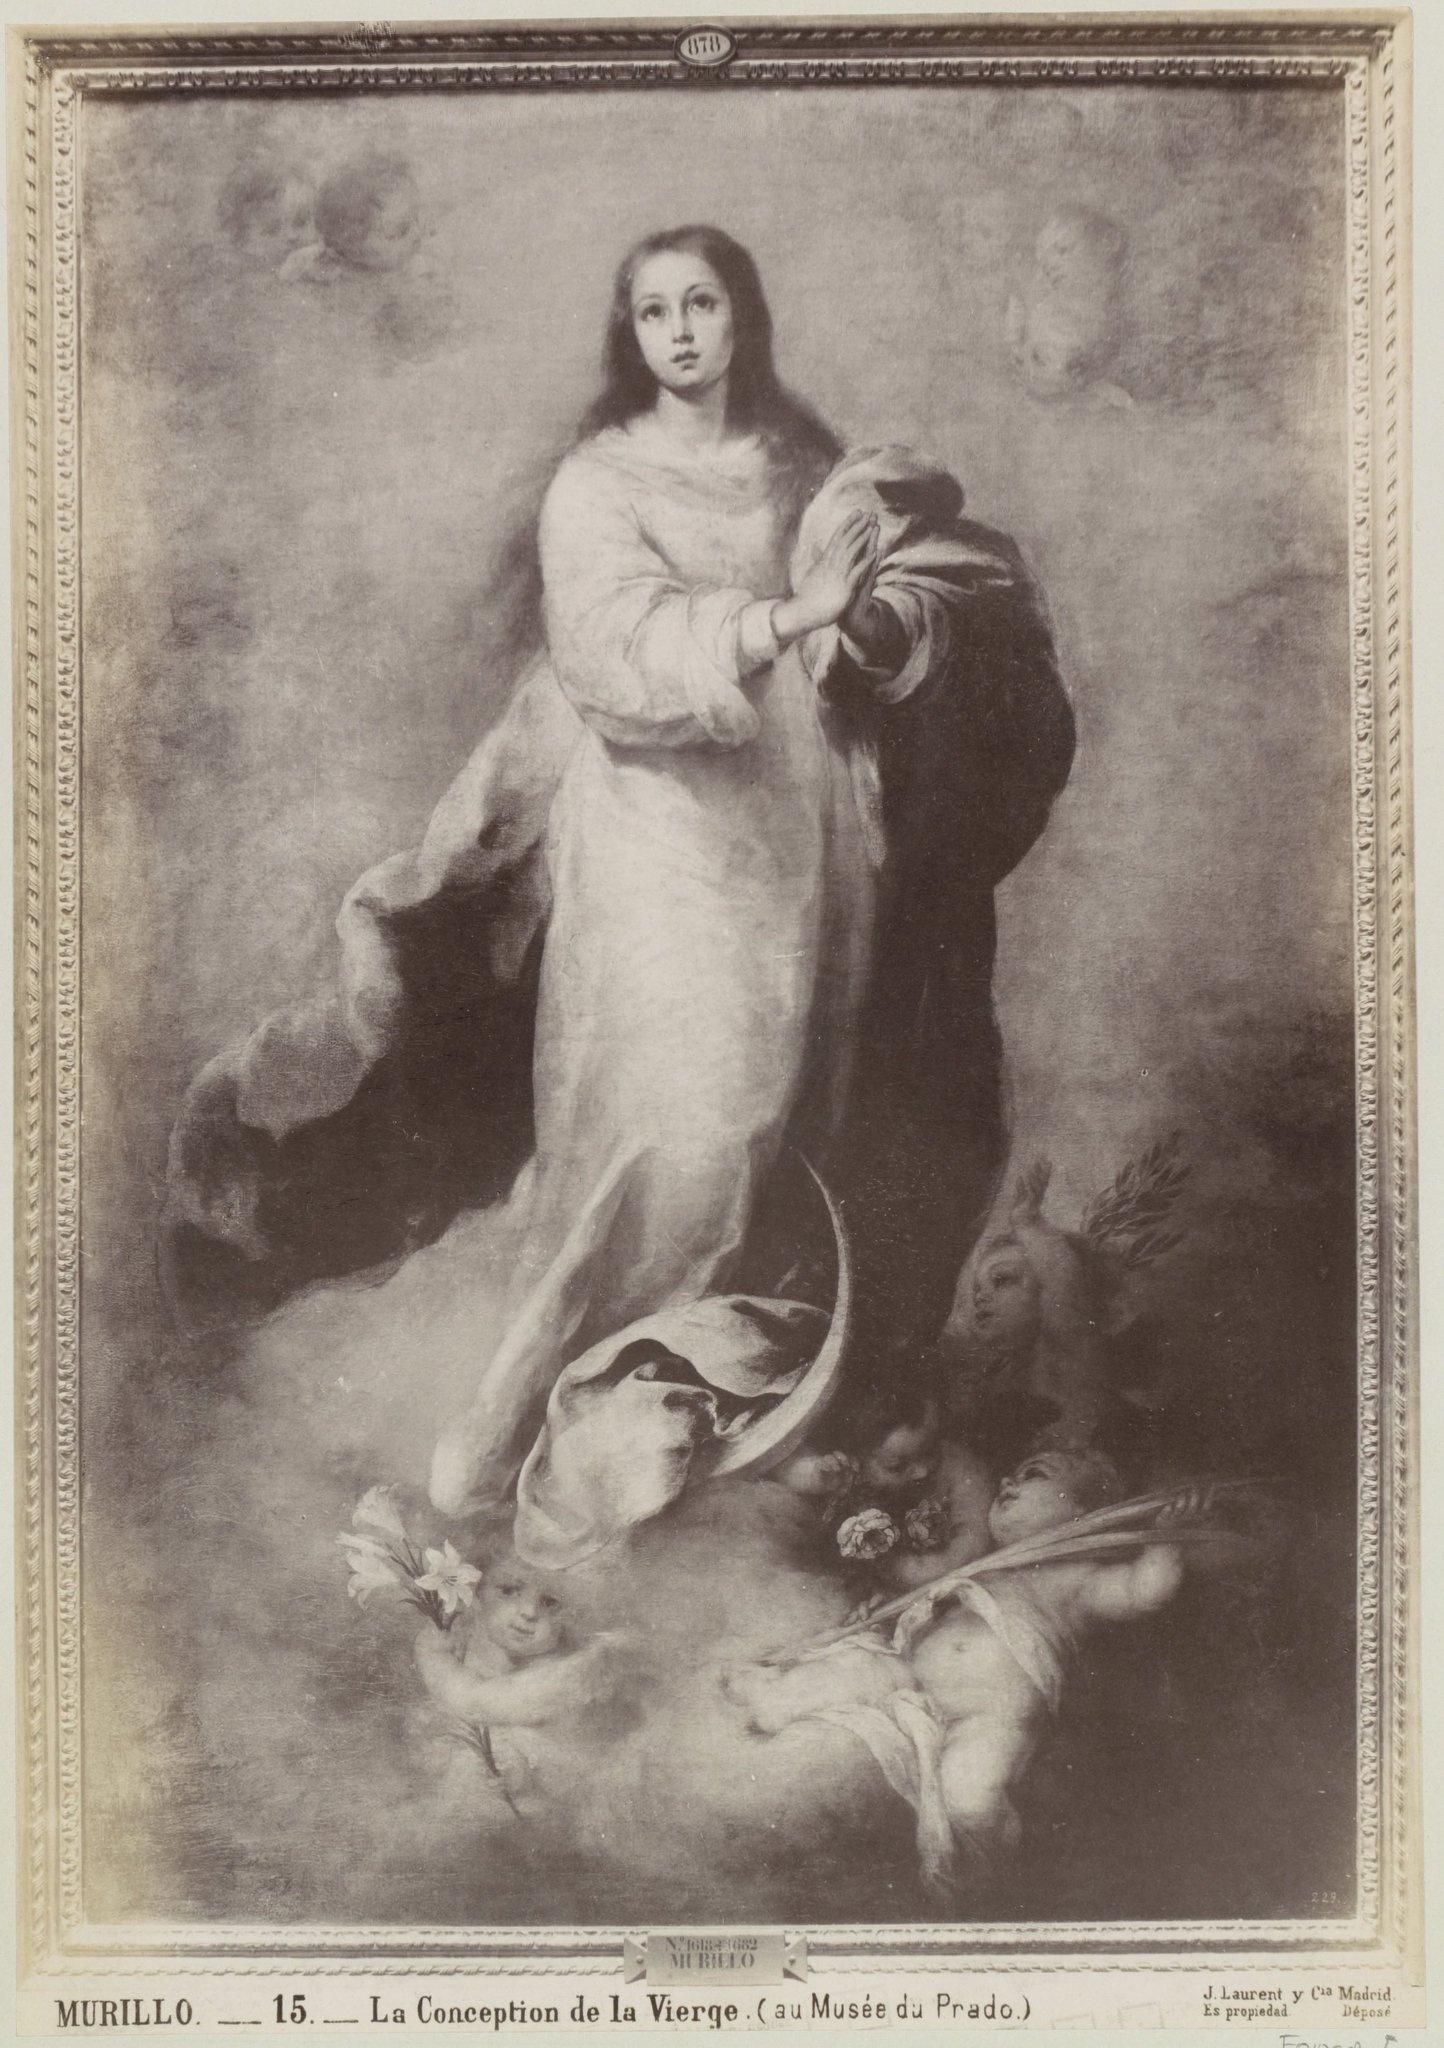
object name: photograph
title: Fotoreproductie van een schilderij door Bartolomé Esteban Murillo, voorstellend de Onbevlekte Ontvangenis van Maria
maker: juan laurent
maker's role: publisher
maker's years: 1816-1896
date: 1857-1880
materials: cardboard, paper, photographic support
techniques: albumen print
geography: madrid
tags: 'immaculata', 'purisima': mary, usually standing on a crescent moon, descending from heaven, exempt from original sin (sometimes trampling serpent)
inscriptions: negative number: ‘15’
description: Onderdeel van Reisalbum met foto's van bezienswaardigheden in Spanje en Marokko.